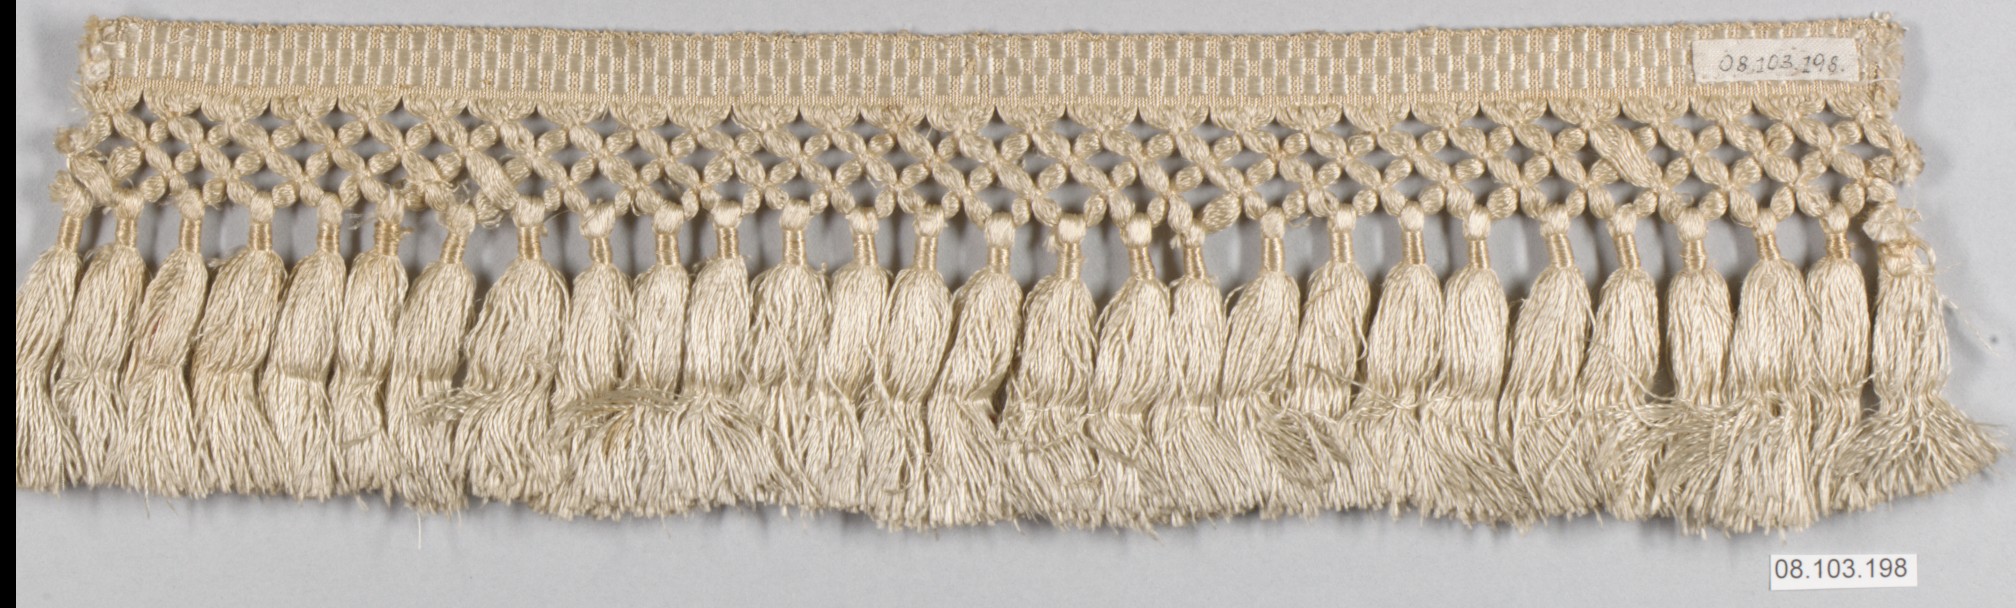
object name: fringe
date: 1801-1900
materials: silk